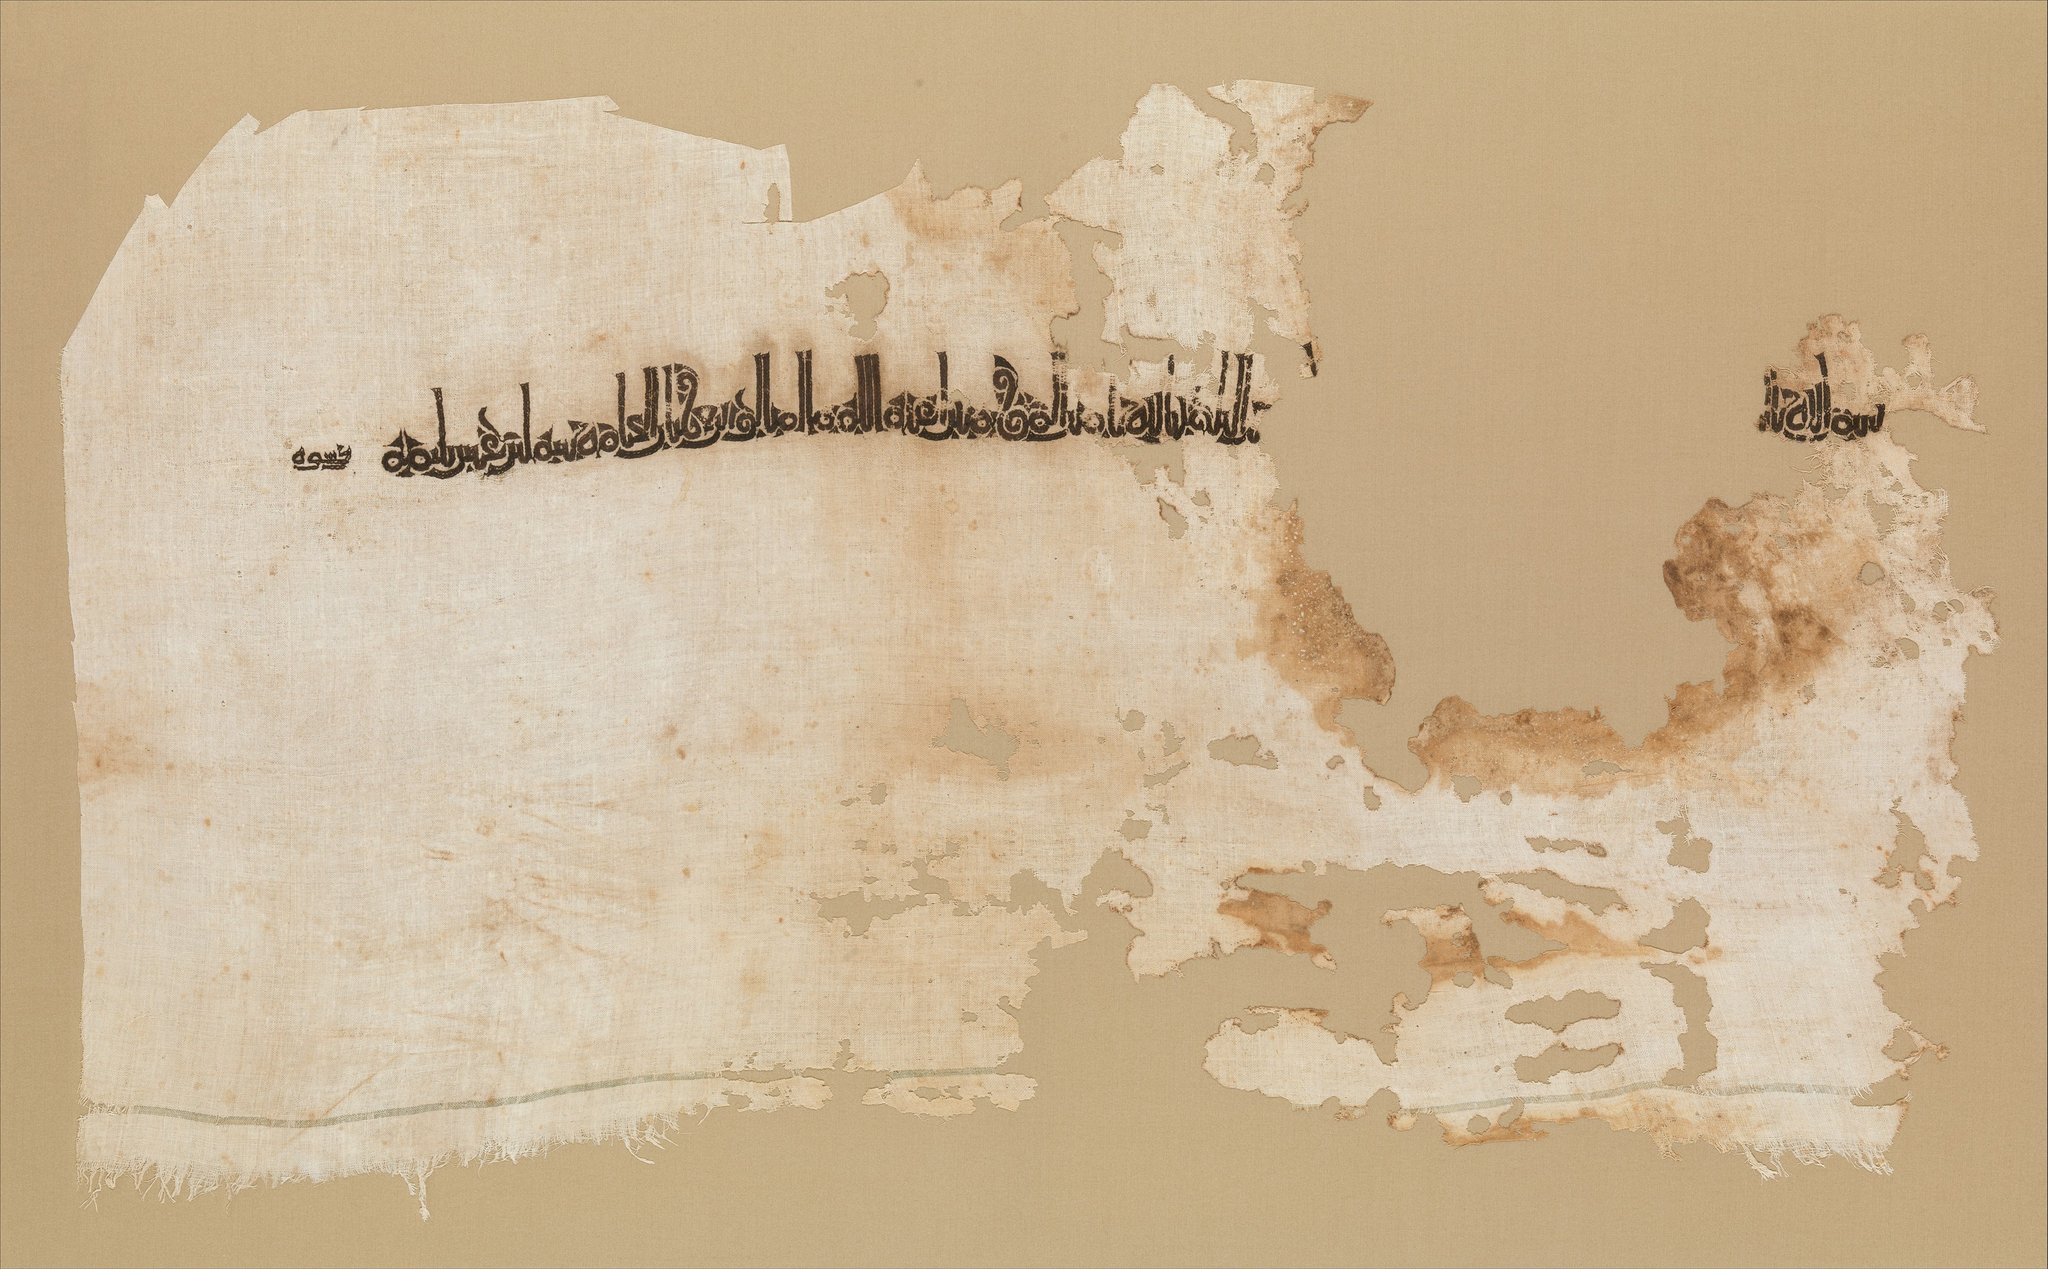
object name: textile fragment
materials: linen, silk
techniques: embroidery, weave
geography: egypt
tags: arabic